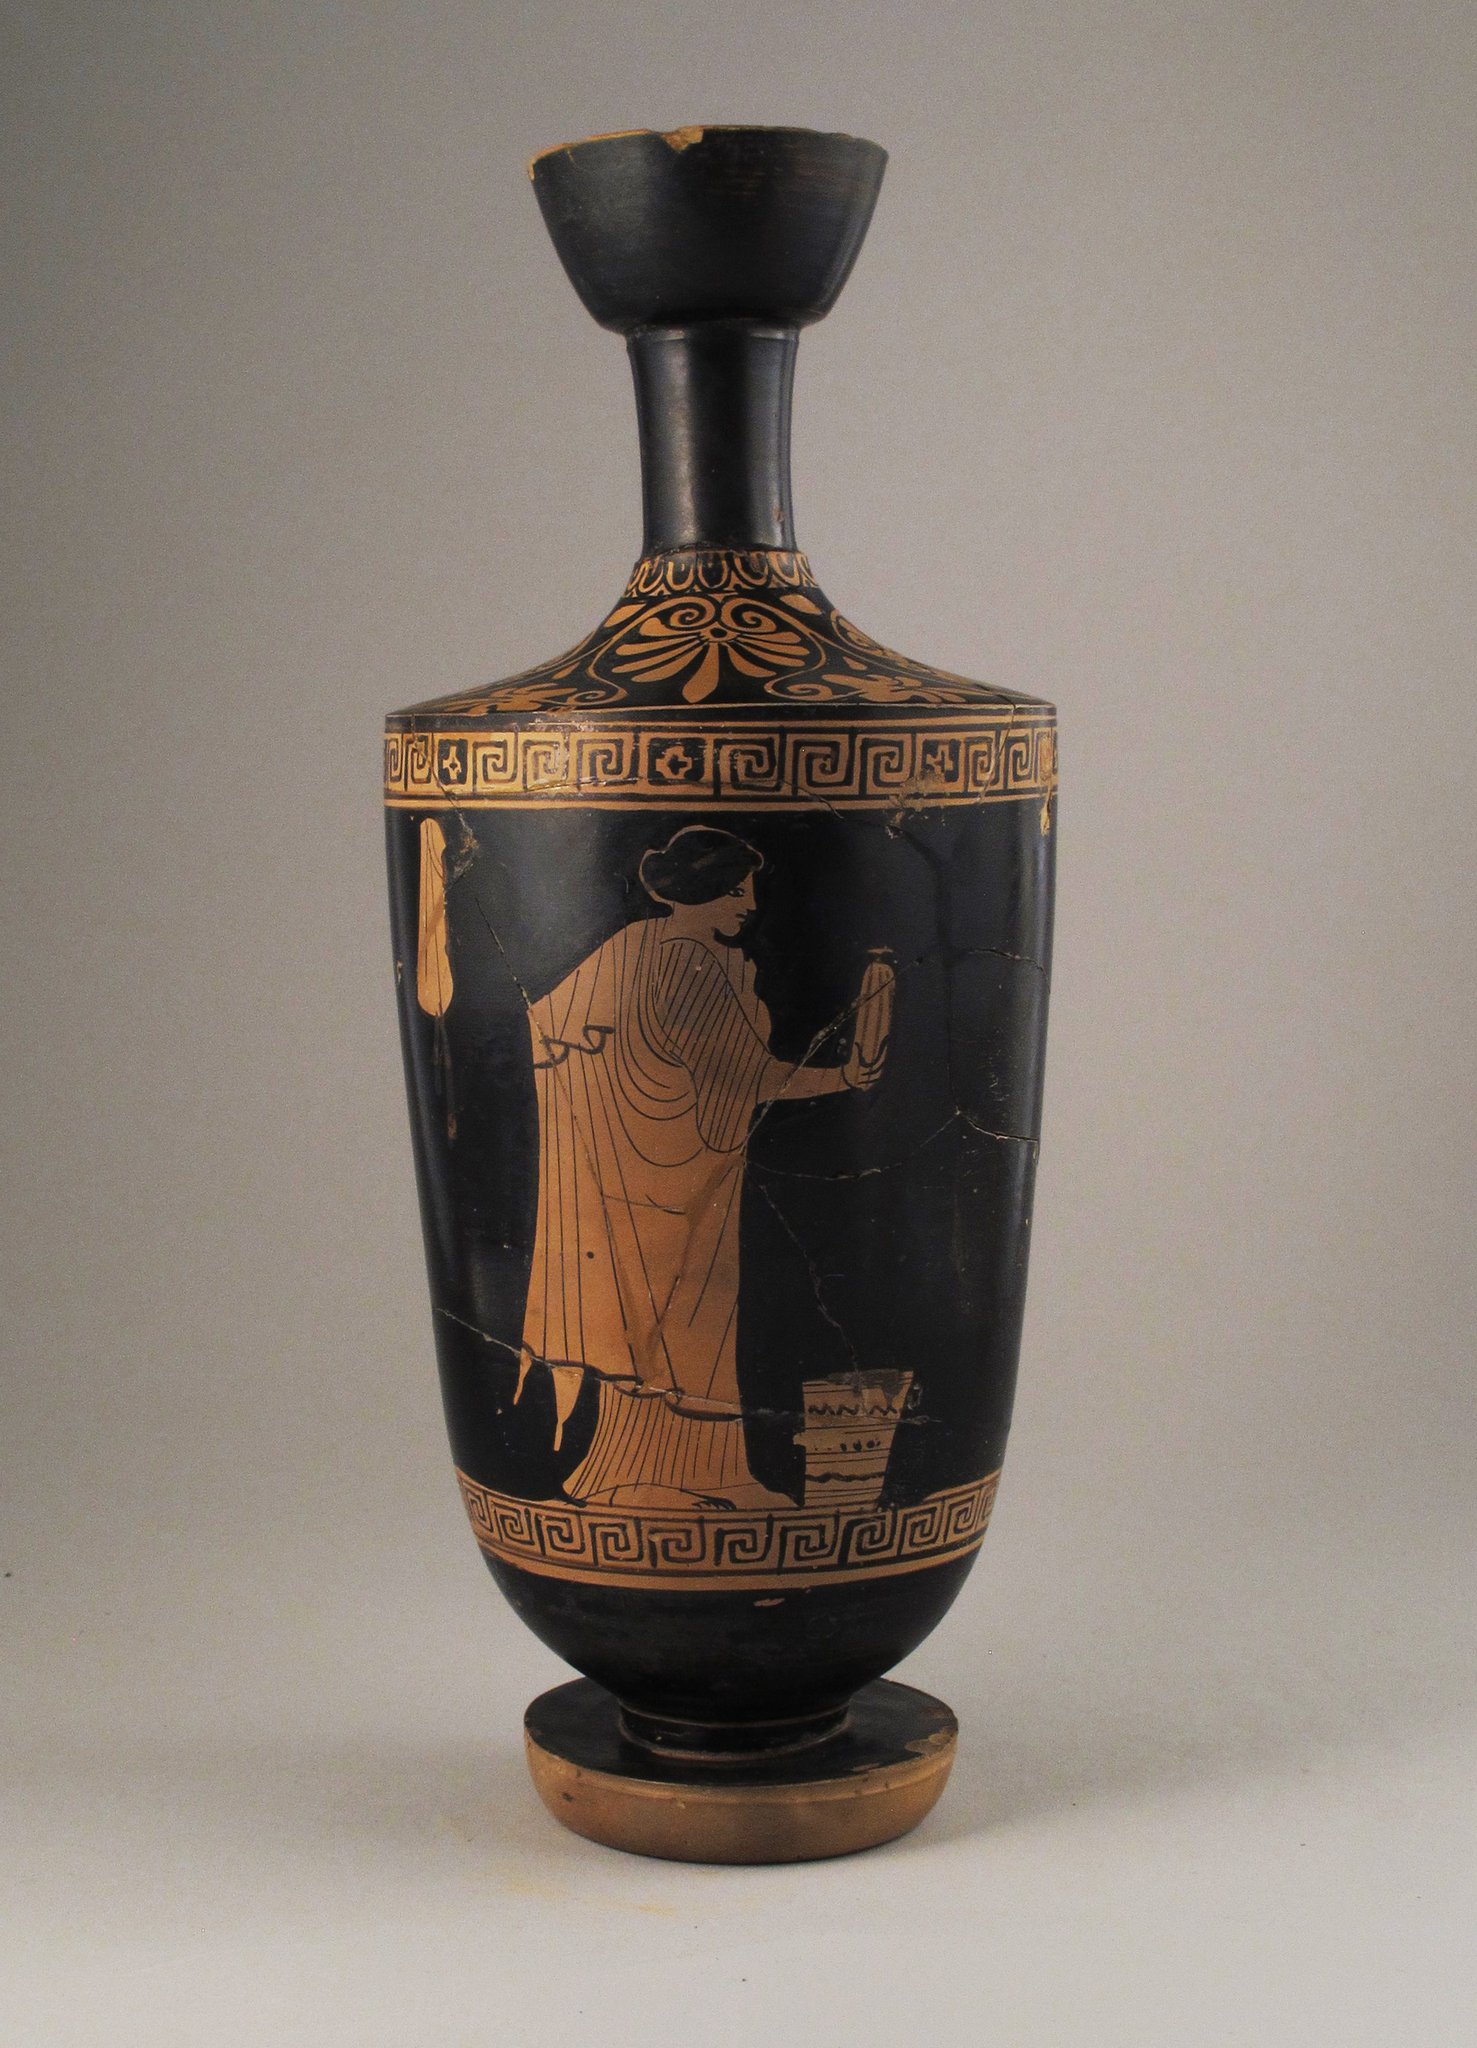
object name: lekythos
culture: greek, attic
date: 475-451 BCE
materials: terracotta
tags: women